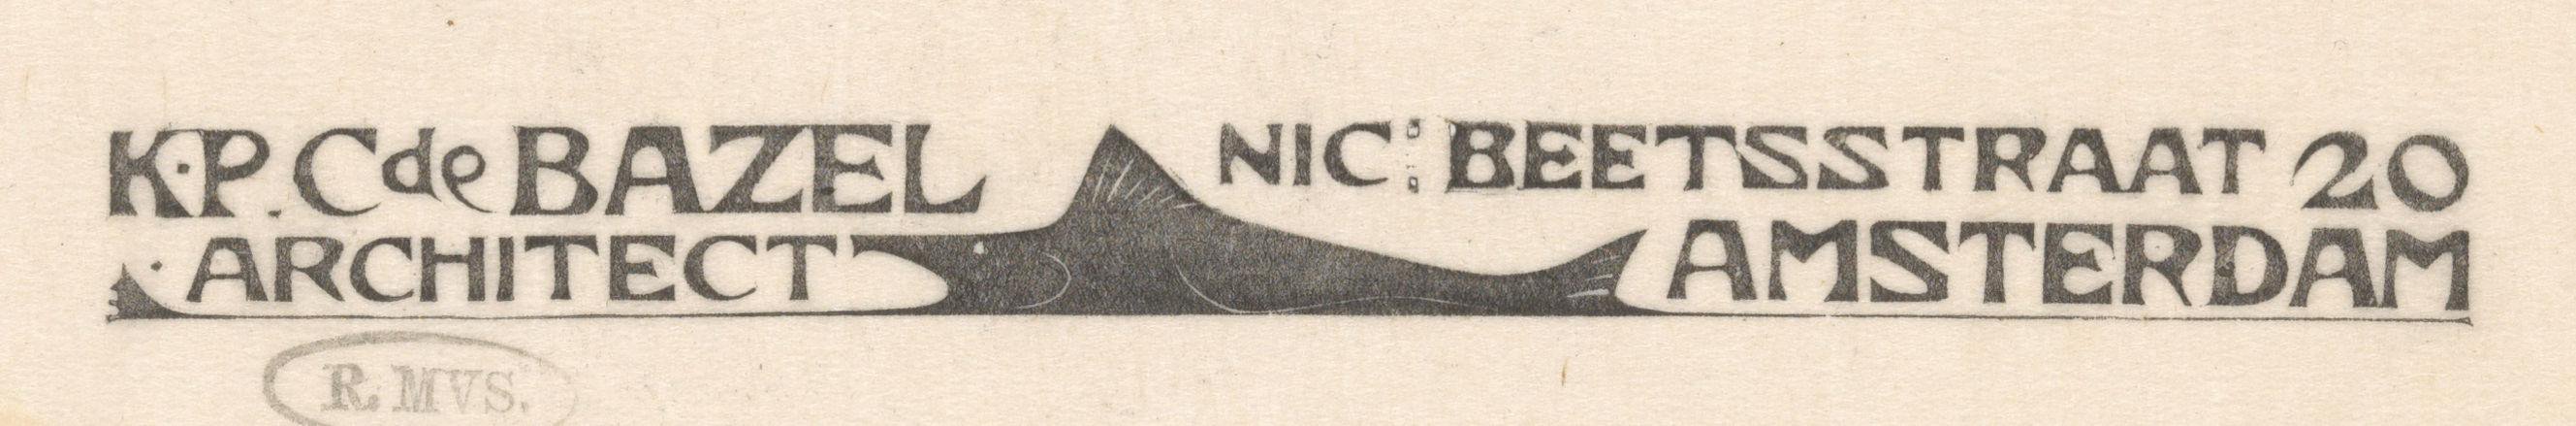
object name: letterhead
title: Briefhoofd van Karel de Bazel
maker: karel petrus cornelis de bazel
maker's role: draughtsman, print maker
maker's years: 1869-1923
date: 1896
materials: paper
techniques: woodcut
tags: den helder, amsterdam, print maker, draughtsman, karel petrus cornelis de bazel, fishes, letter, envelope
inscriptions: collector's mark: Lugt 2228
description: Briefhoofd van K.P.C. de Bazel, architect, Nicolaas Beetsstraat 20 te Amsterdam. In het midden een vis met geopende mond.